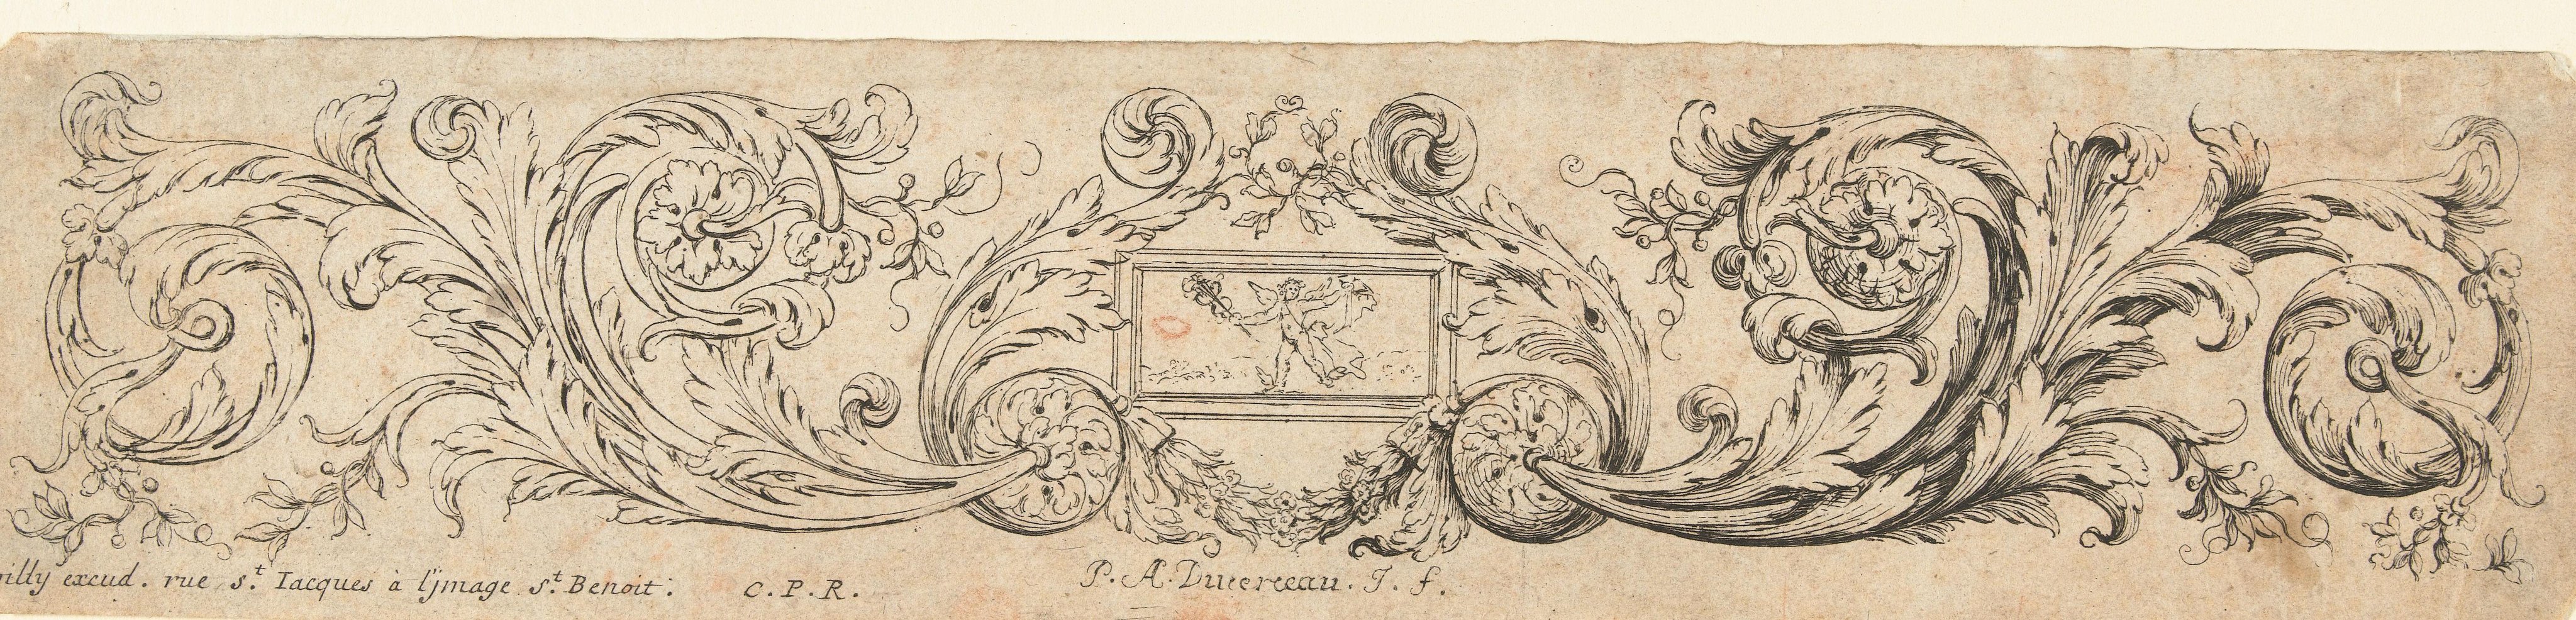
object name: print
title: Twee bladranken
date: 1670-1693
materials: paper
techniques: etching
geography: france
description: In het midden een rechthoekig paneel met een amoretto die een caduceus vasthoudt.